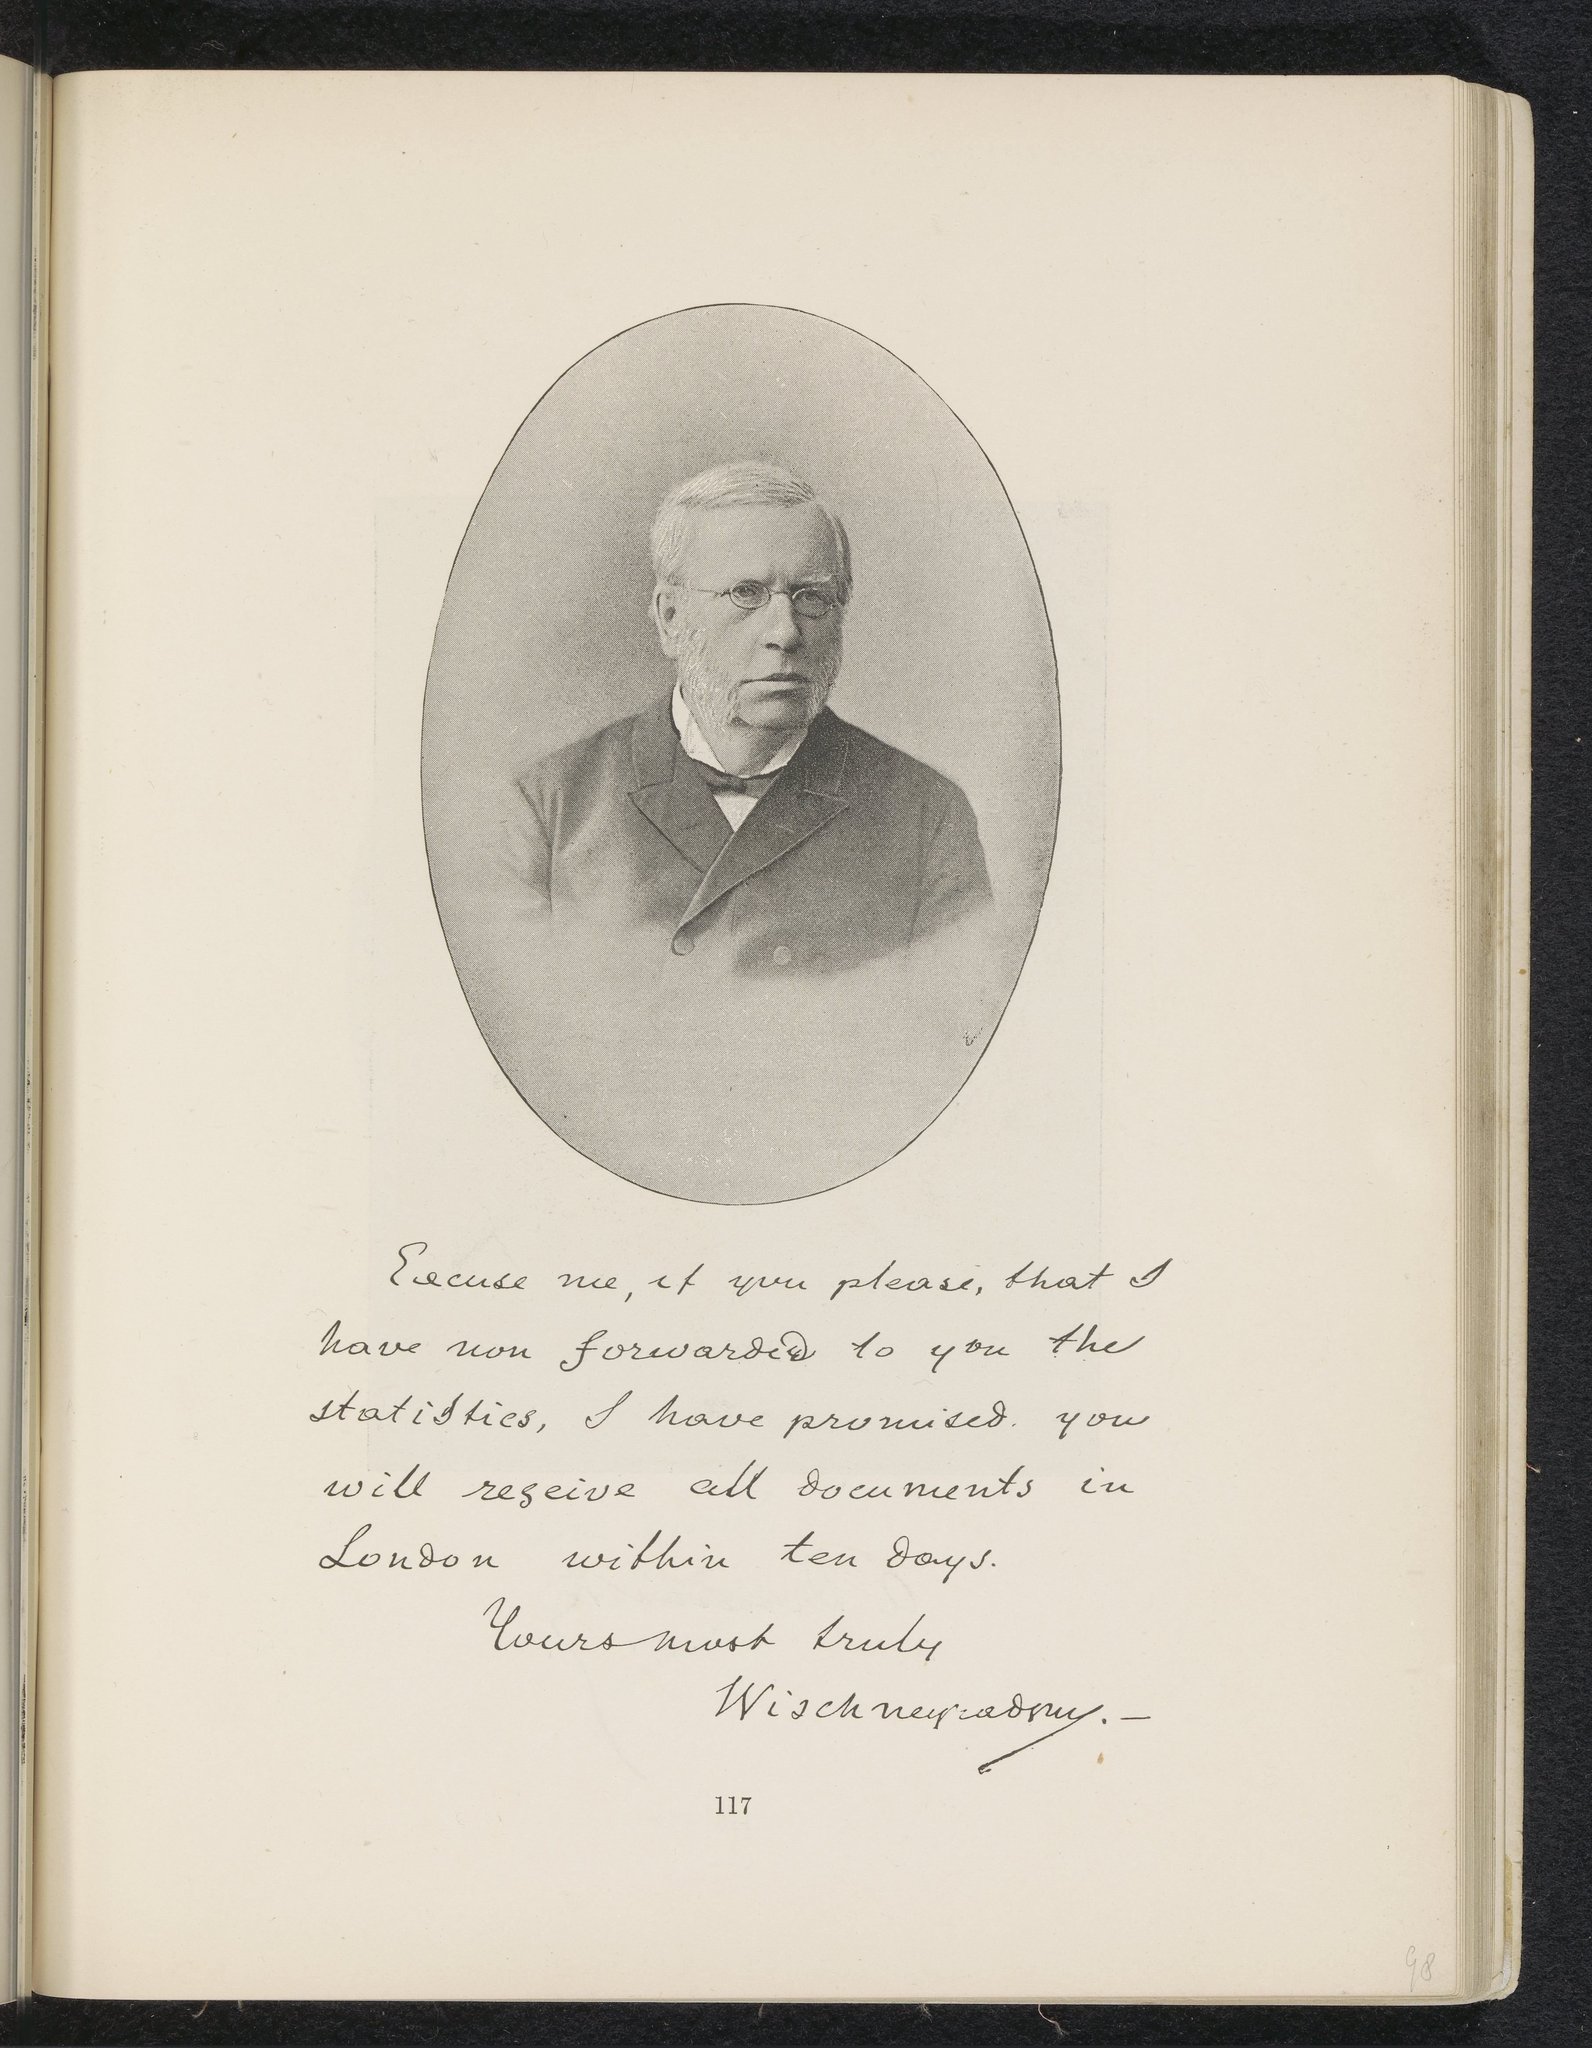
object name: page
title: Portret van Ivan Vyshnegradsky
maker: Anonymous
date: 1881-1891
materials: paper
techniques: autotype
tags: politician, e.g. party leader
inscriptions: inscription